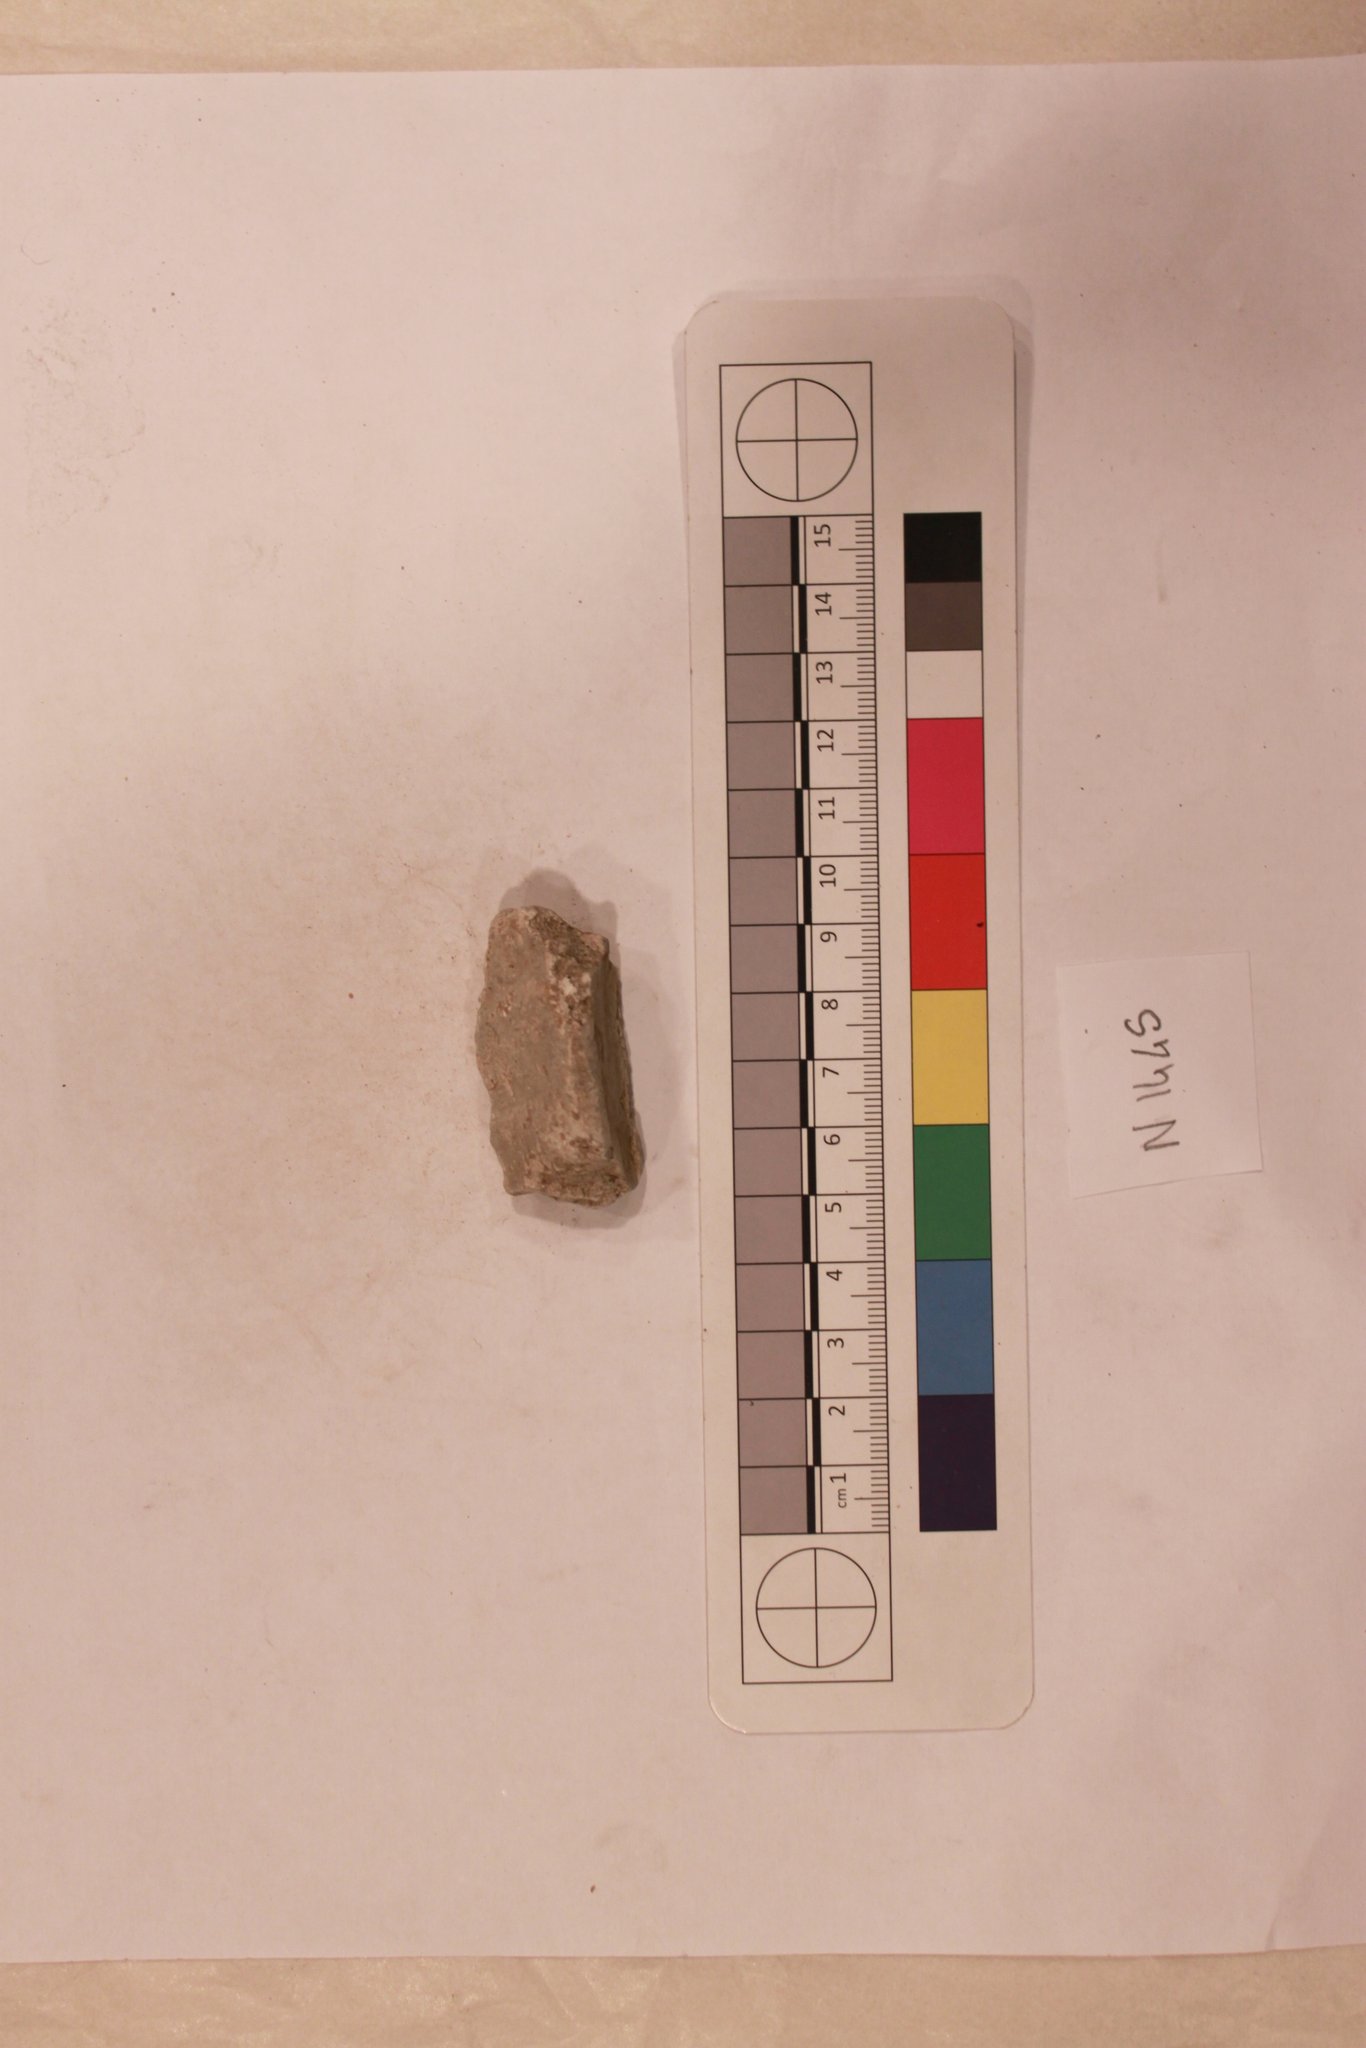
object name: fragment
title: Stucco Fragment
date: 701-1200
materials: plaster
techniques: carving, painting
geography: iran